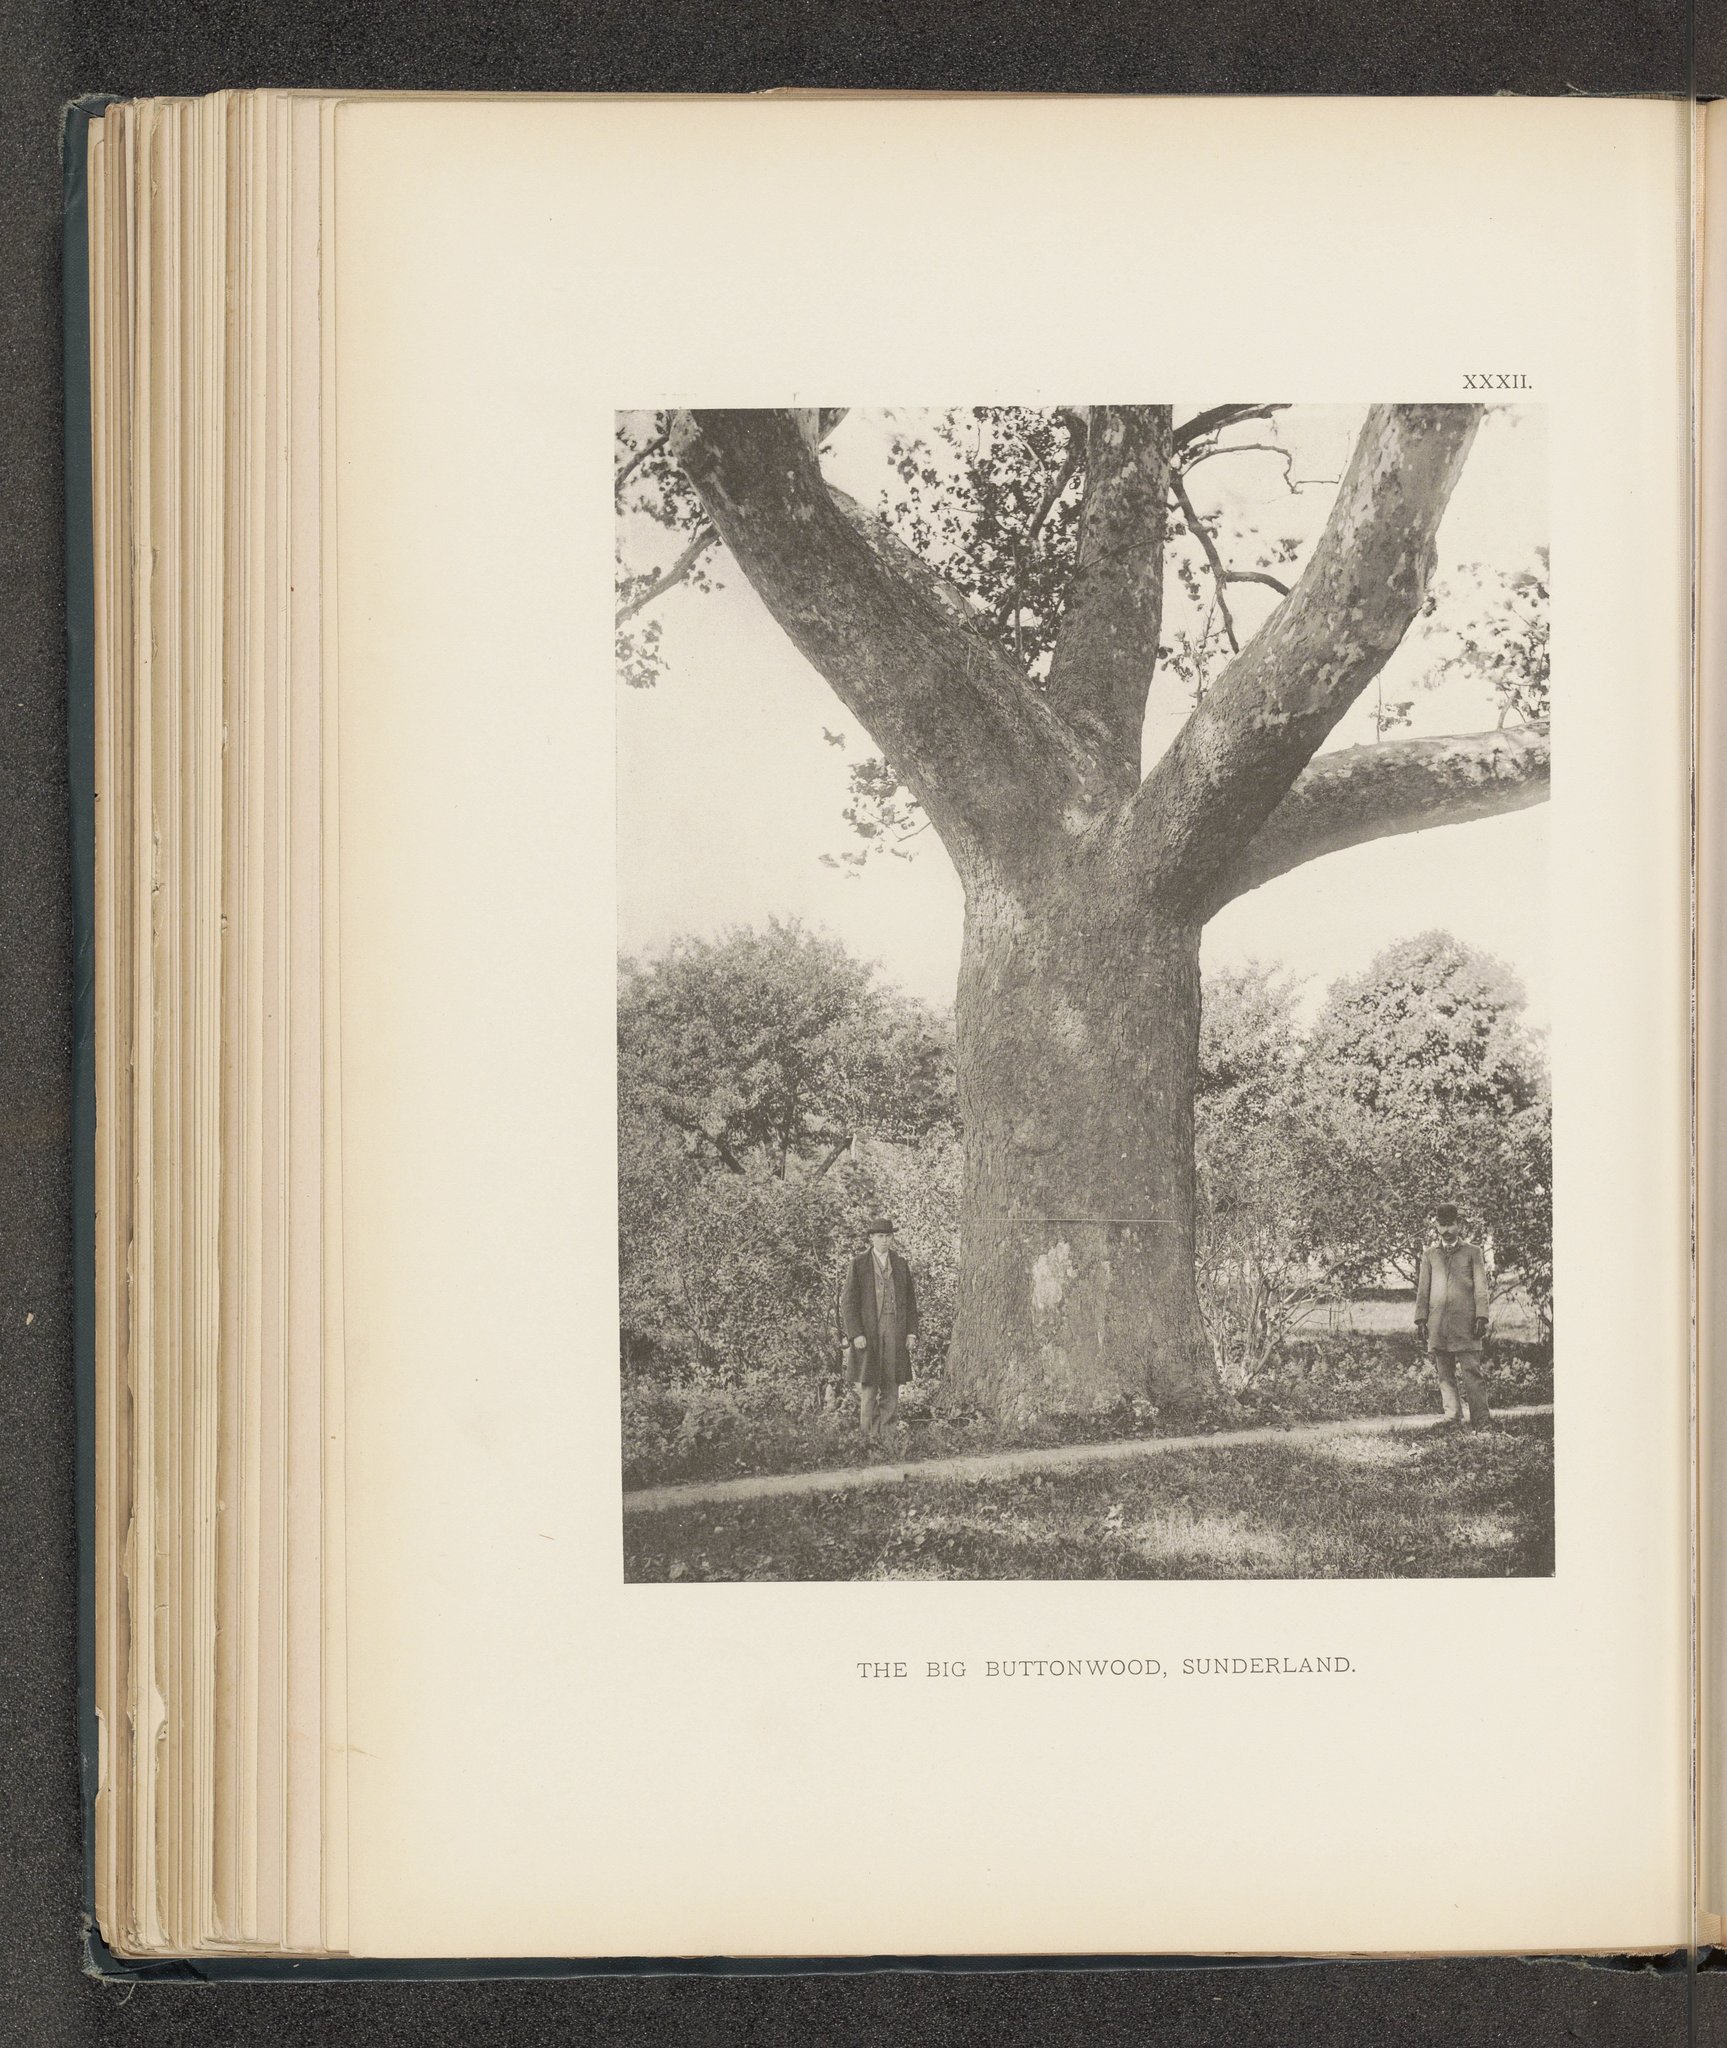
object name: page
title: The big buttonwood, Sunderland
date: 1880-1890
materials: paper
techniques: photograph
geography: sunderland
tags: trees: plane-tree, trees (+ stem, trunk)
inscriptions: number: ‘XXXII.’